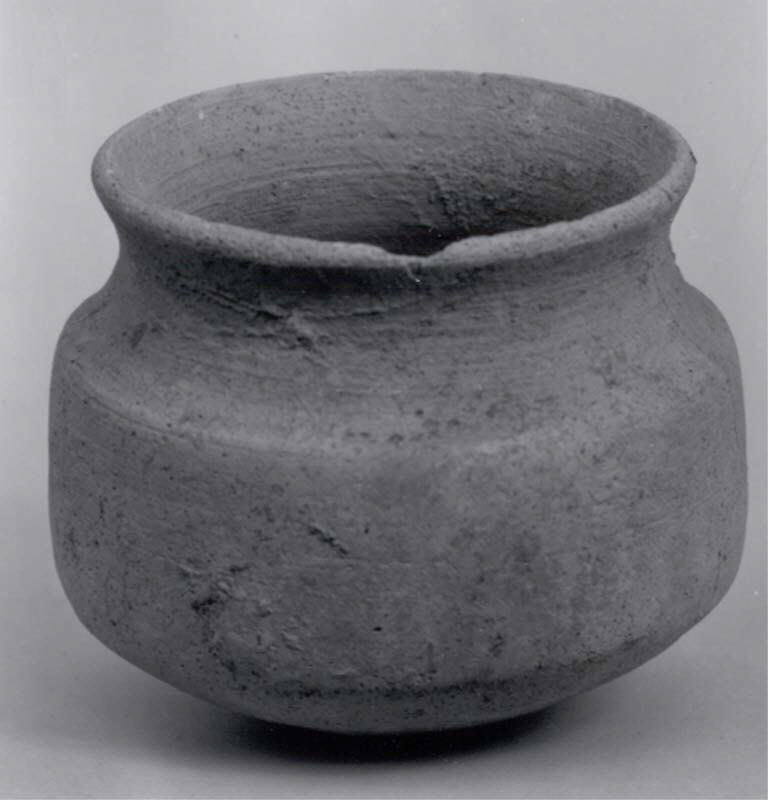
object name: jar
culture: iranian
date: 2600-2300 BCE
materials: ceramic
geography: iran, luristan